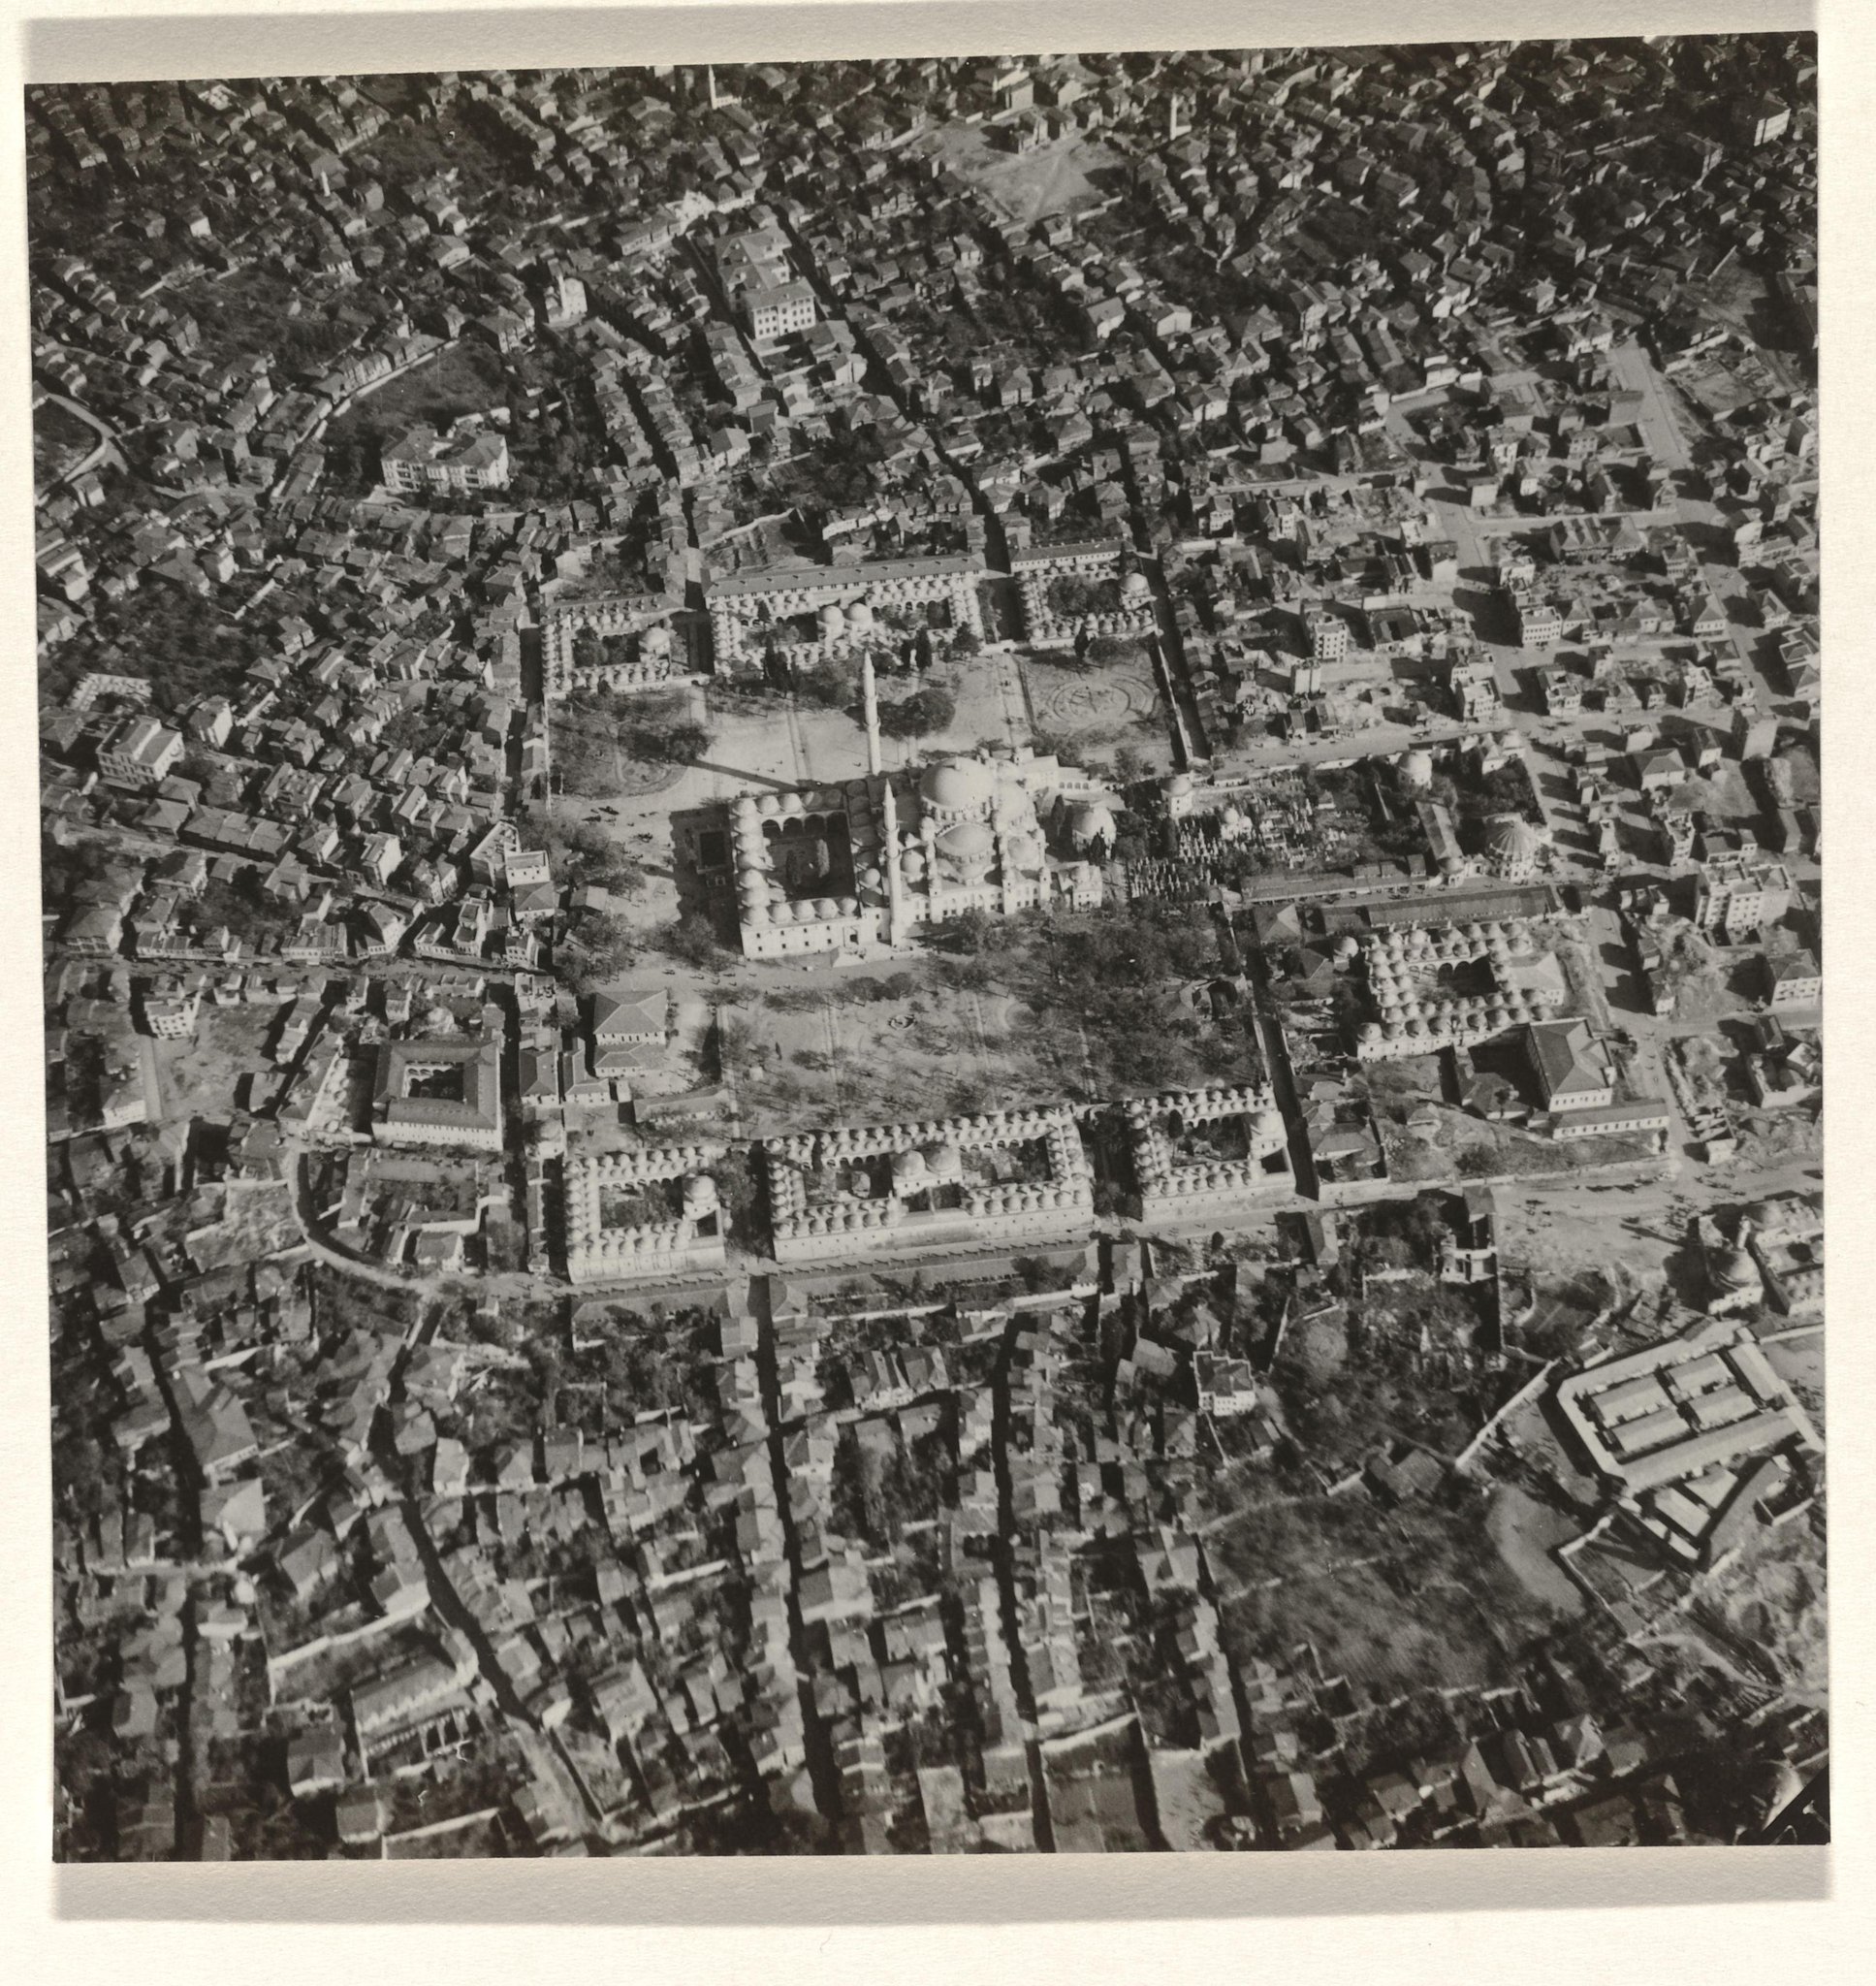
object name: photograph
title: Luchtfoto van Istanbul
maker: Anonymous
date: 1930-1975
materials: photographic support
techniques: gelatin silver print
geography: istanbul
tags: istanboel